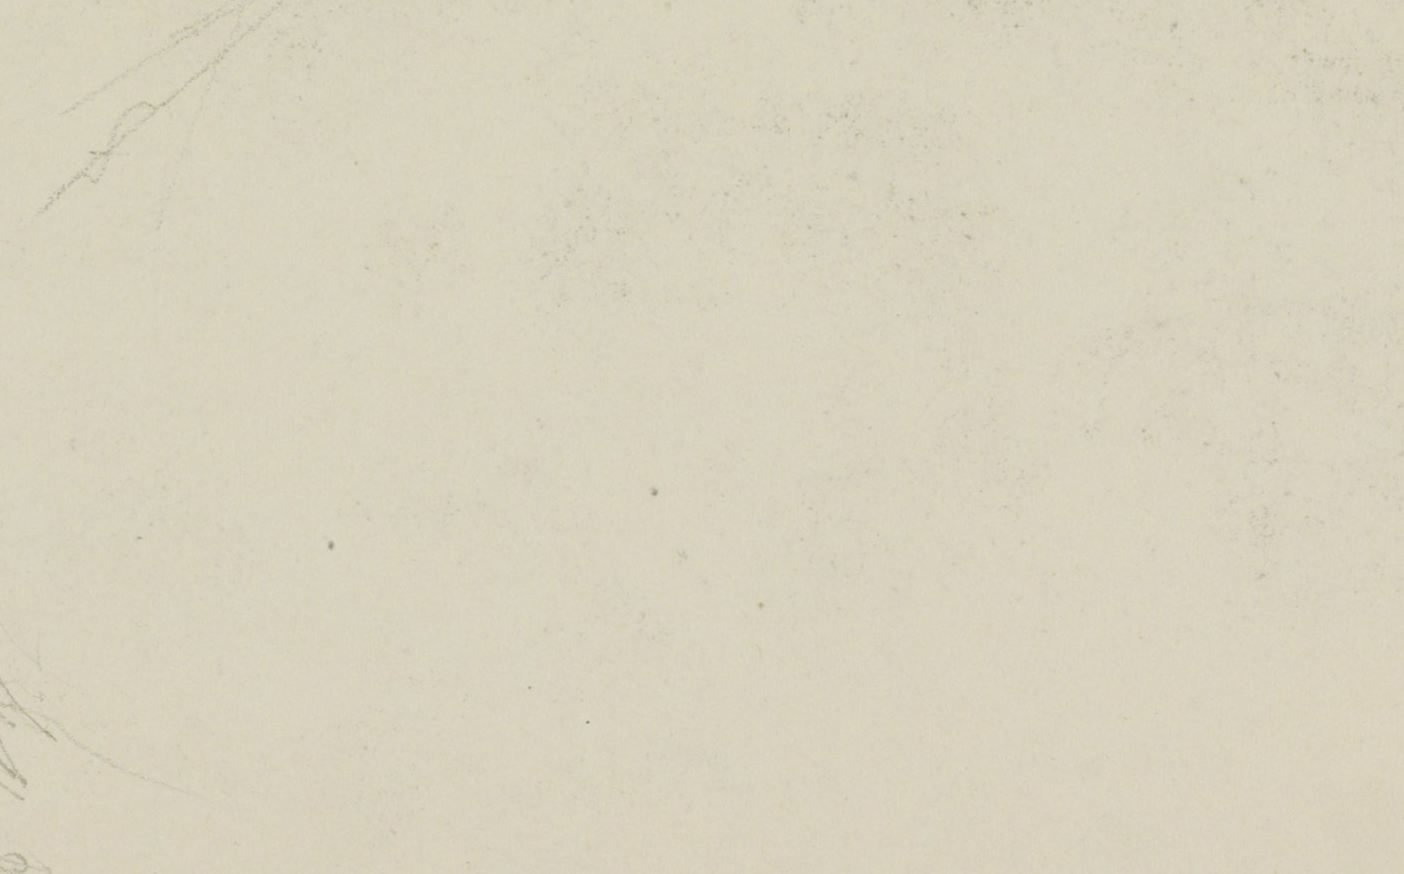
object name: sketchbook leaf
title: Man, in profiel naar links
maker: a.a.l. de grammont-hubrecht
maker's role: draughtsman, painter, print maker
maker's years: 1855-1913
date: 1892-1913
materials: paper, pencil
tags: adult man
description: Blad 31 recto uit een schetsboek met 31 bladen.